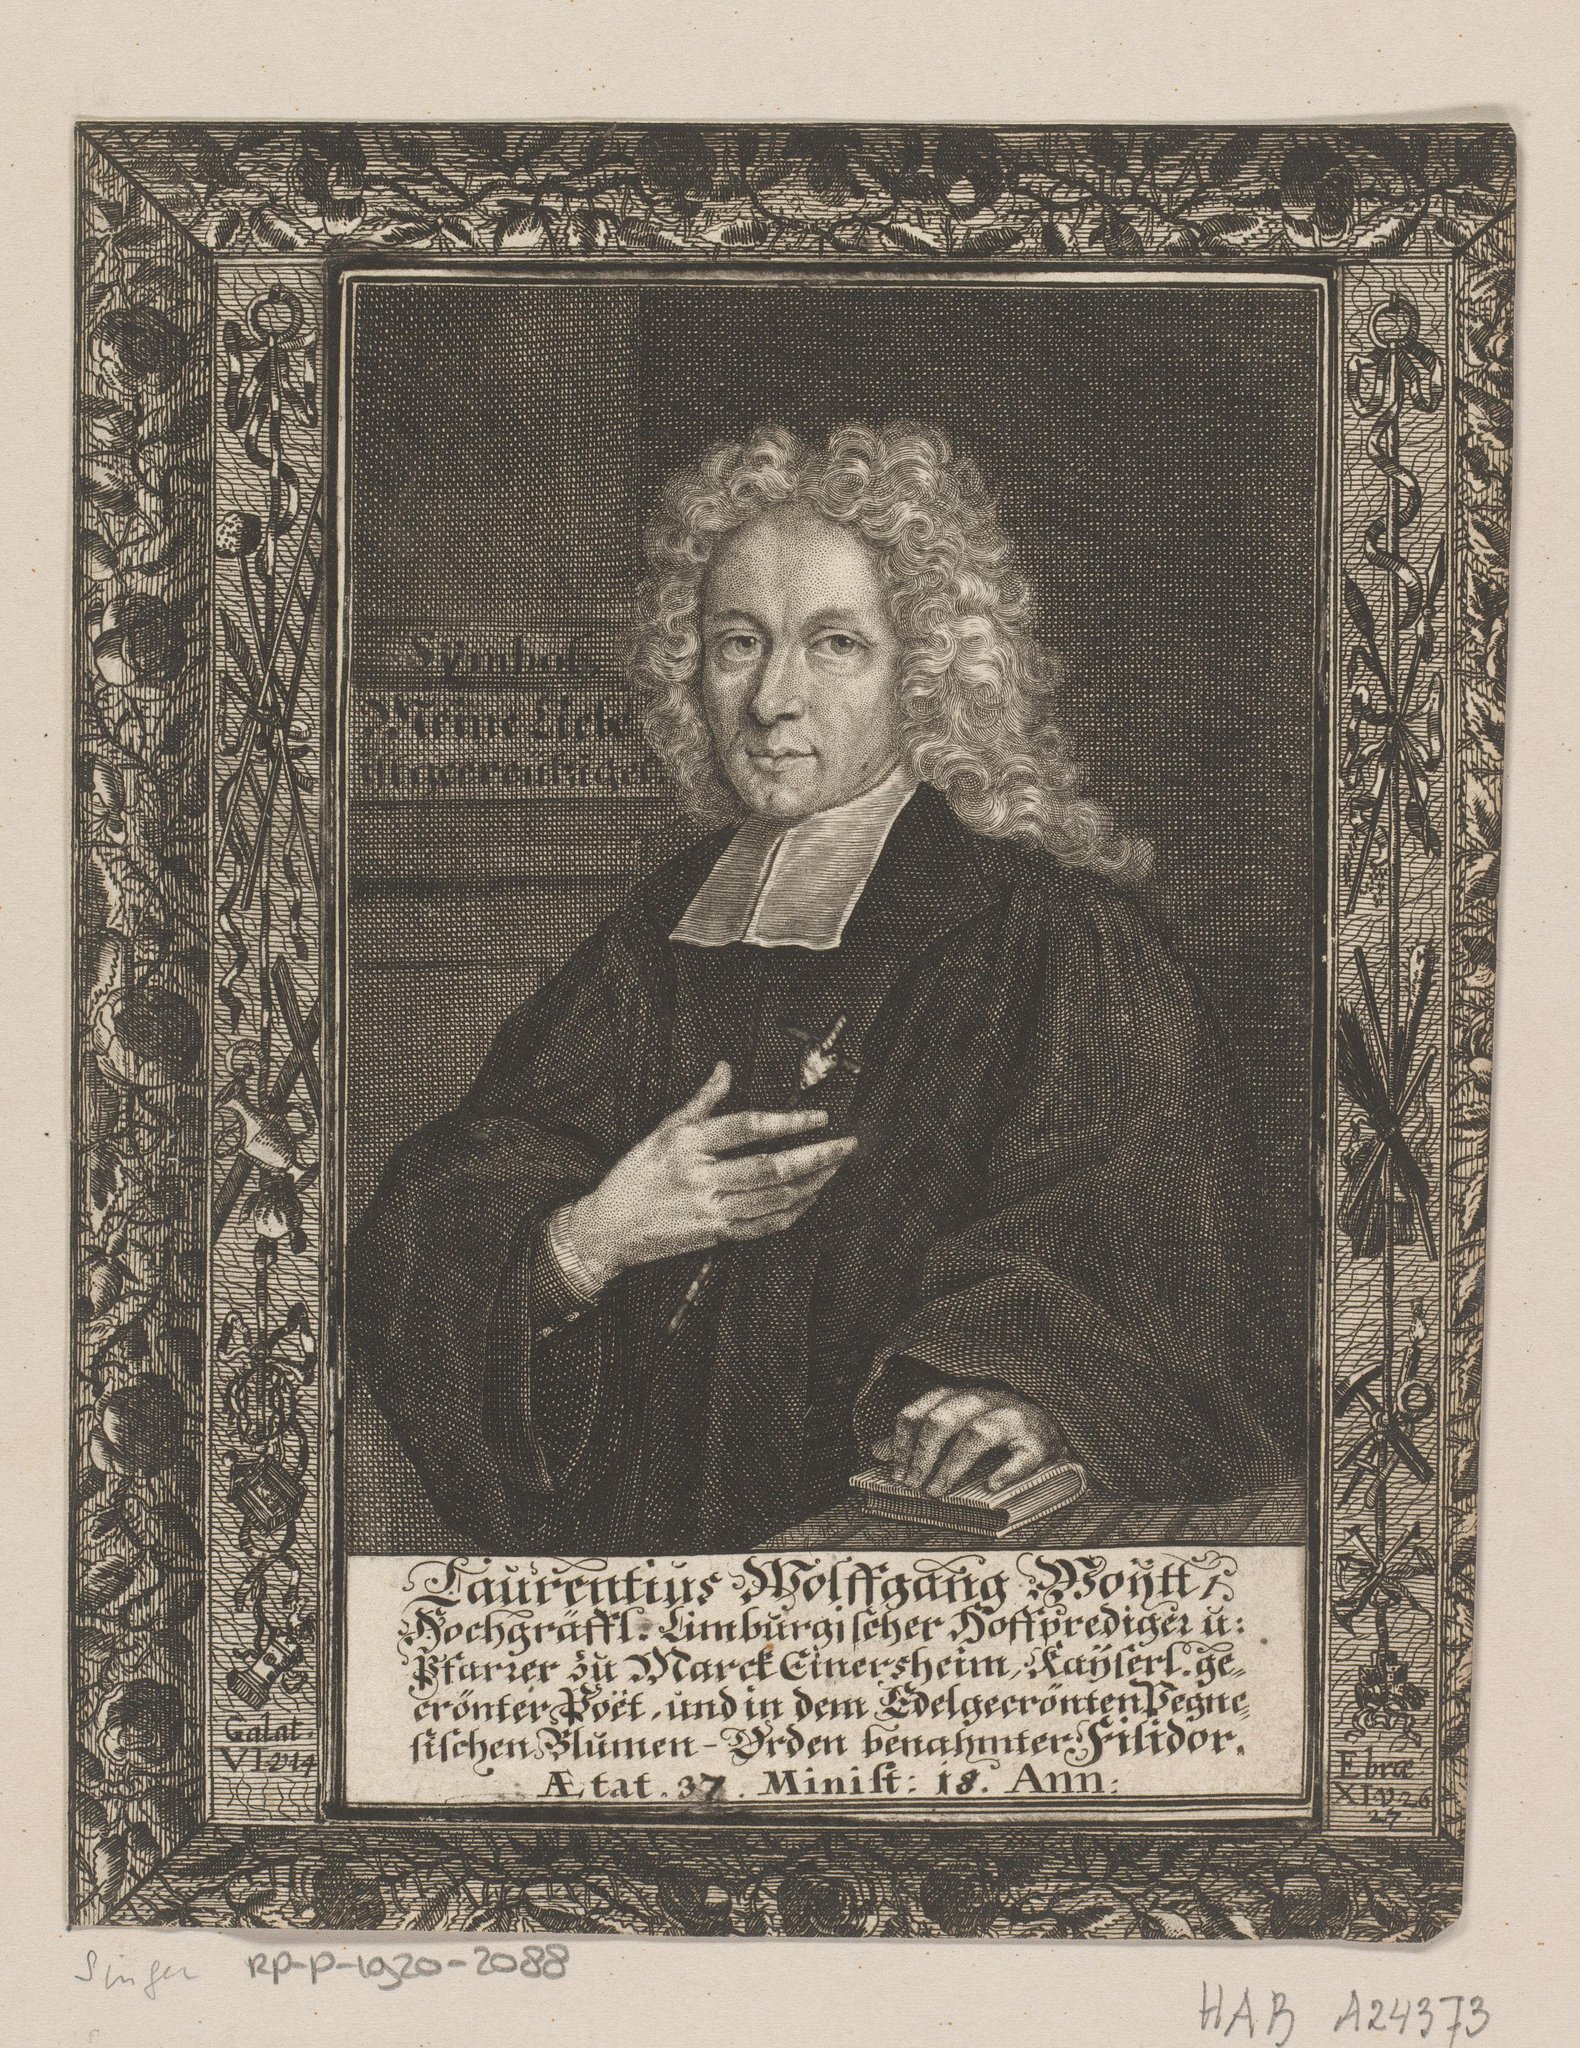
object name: print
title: Portret van Laurentius Wolfgang Woytt op 37-jarige leeftijd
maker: Anonymous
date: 1709-1711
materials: paper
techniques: etching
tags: theologian, historical persons, writer, poet, author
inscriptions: collector's mark: Lugt 2228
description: Met zesregelig onderschrift in het Duits.